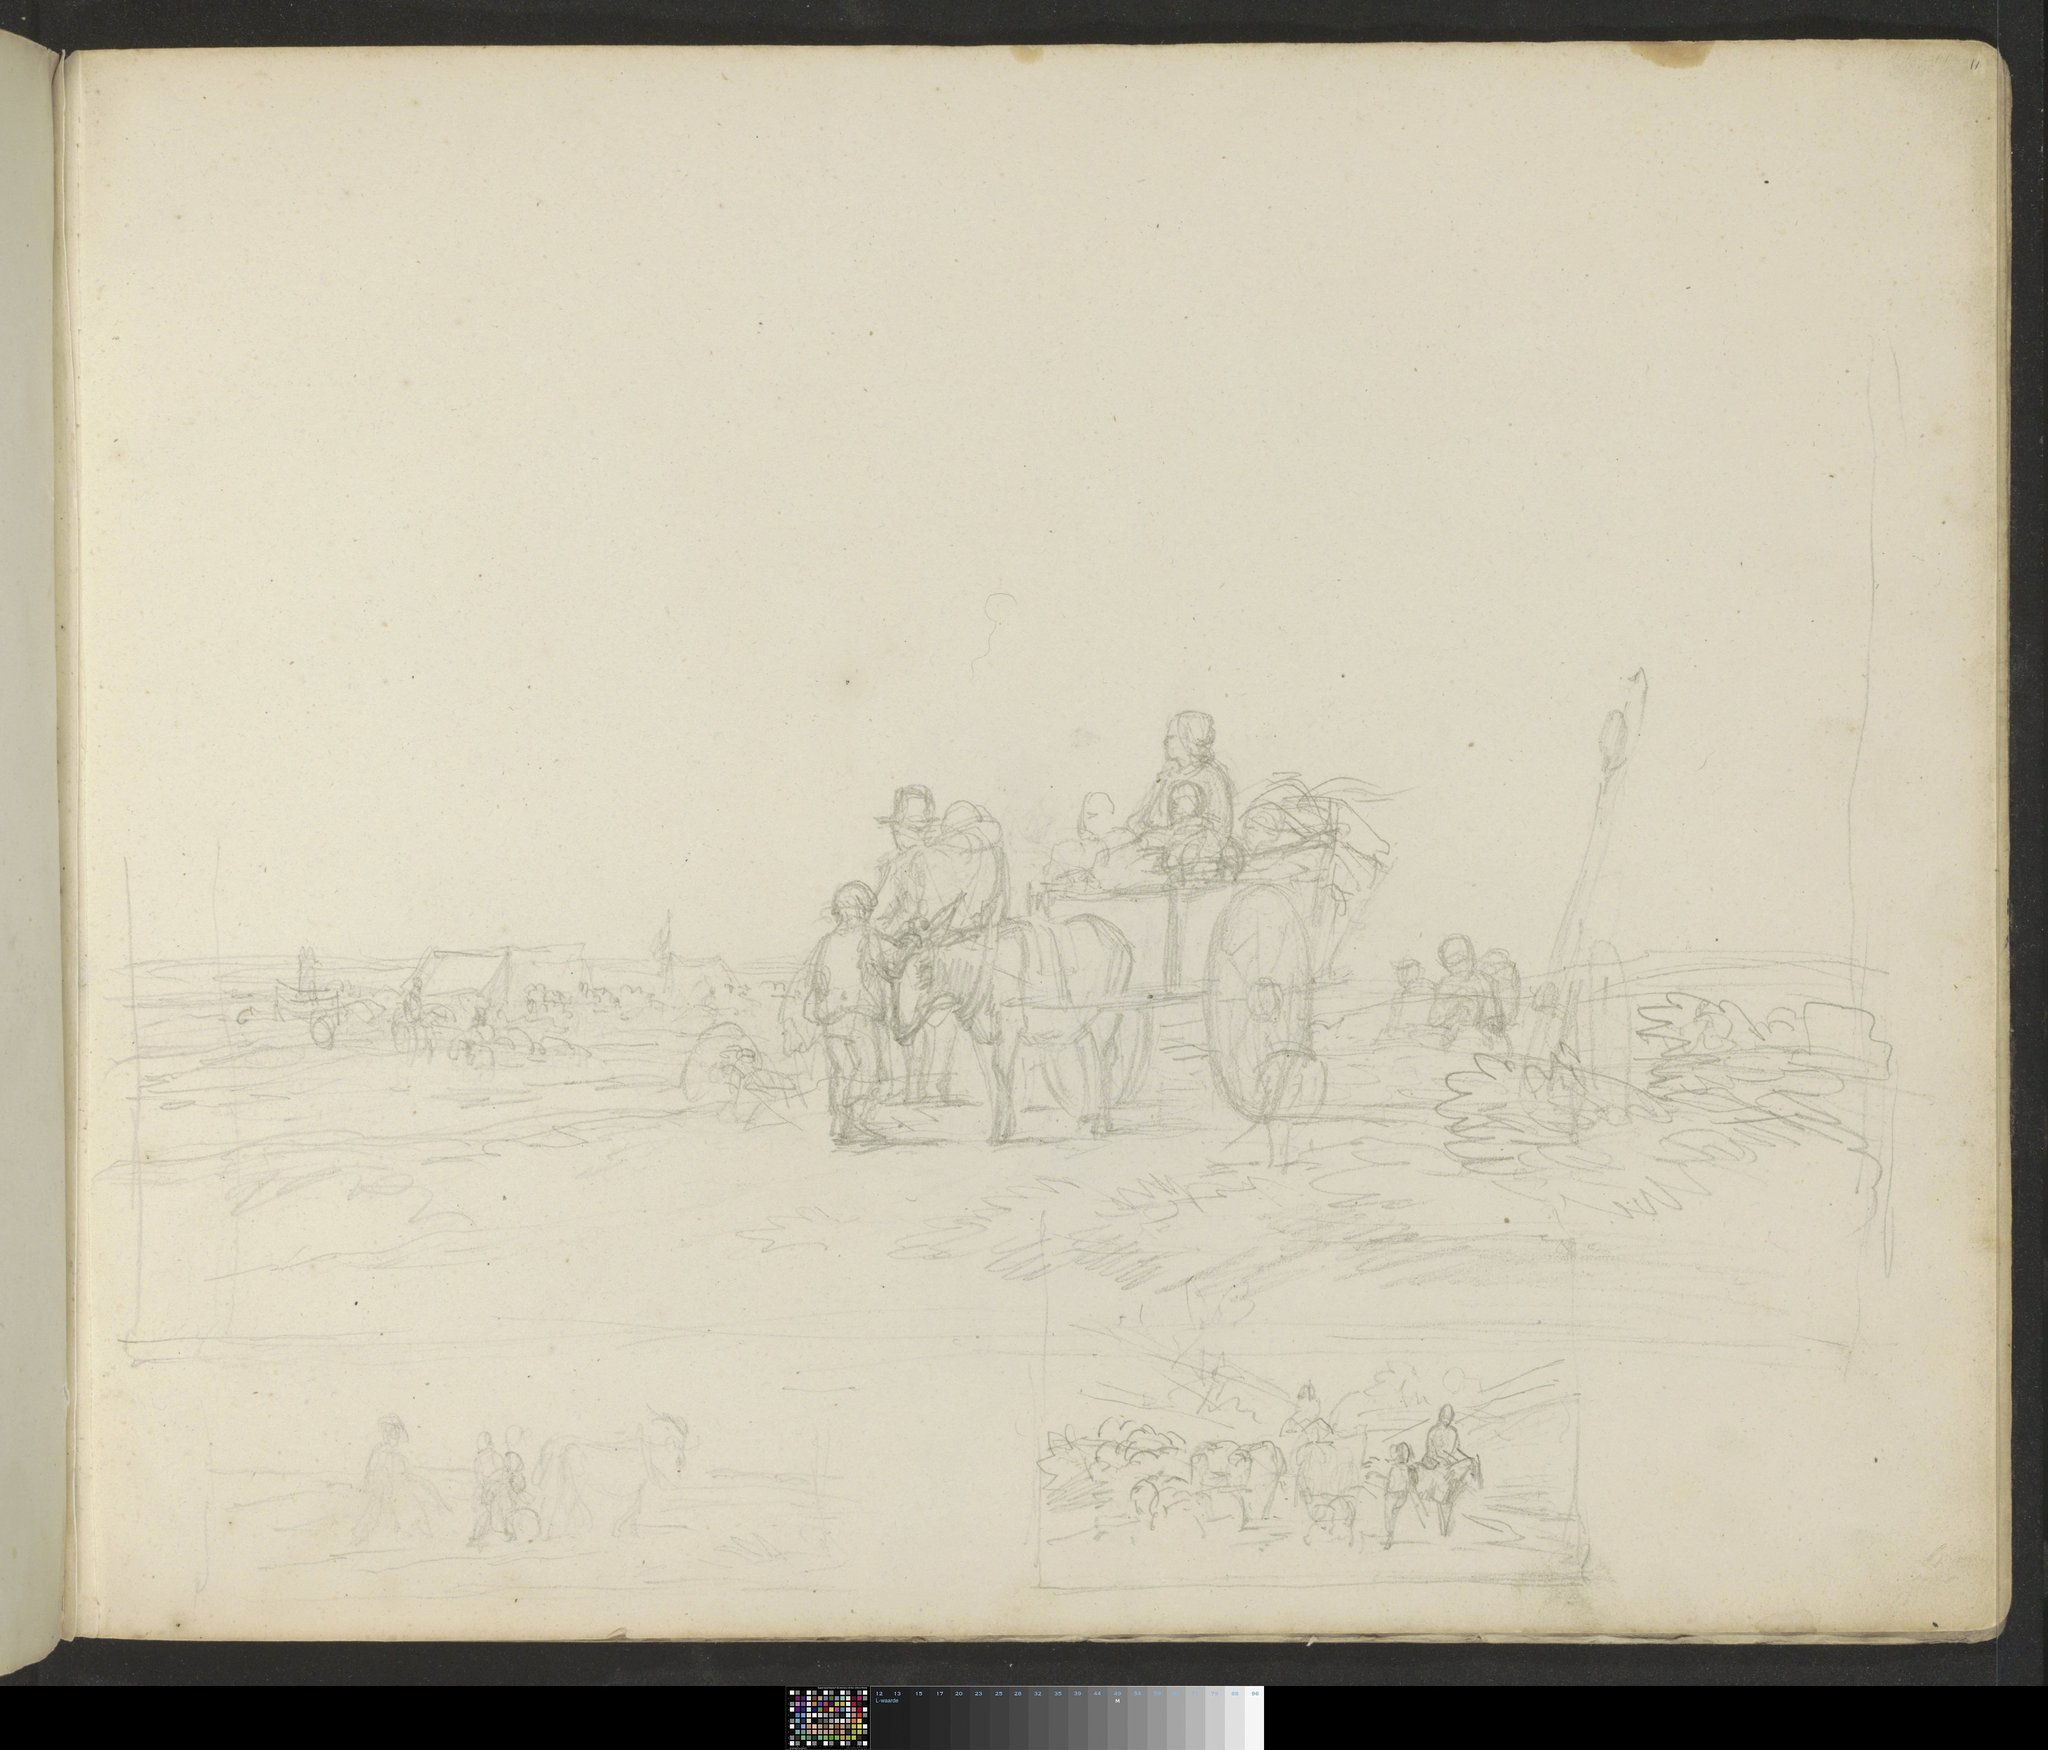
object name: sketchbook leaf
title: Landschap met figuren op en naast een kar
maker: Anonymous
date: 1800-1899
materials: paper, pencil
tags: animal traction, animal-drawn vehicle (carriage etc.), landscapes (+ landscape with figures, staffage)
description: Tevens twee studies in kaders van landschapen met figuren. Blad 11 recto uit een schetsboek met 13 bladen.